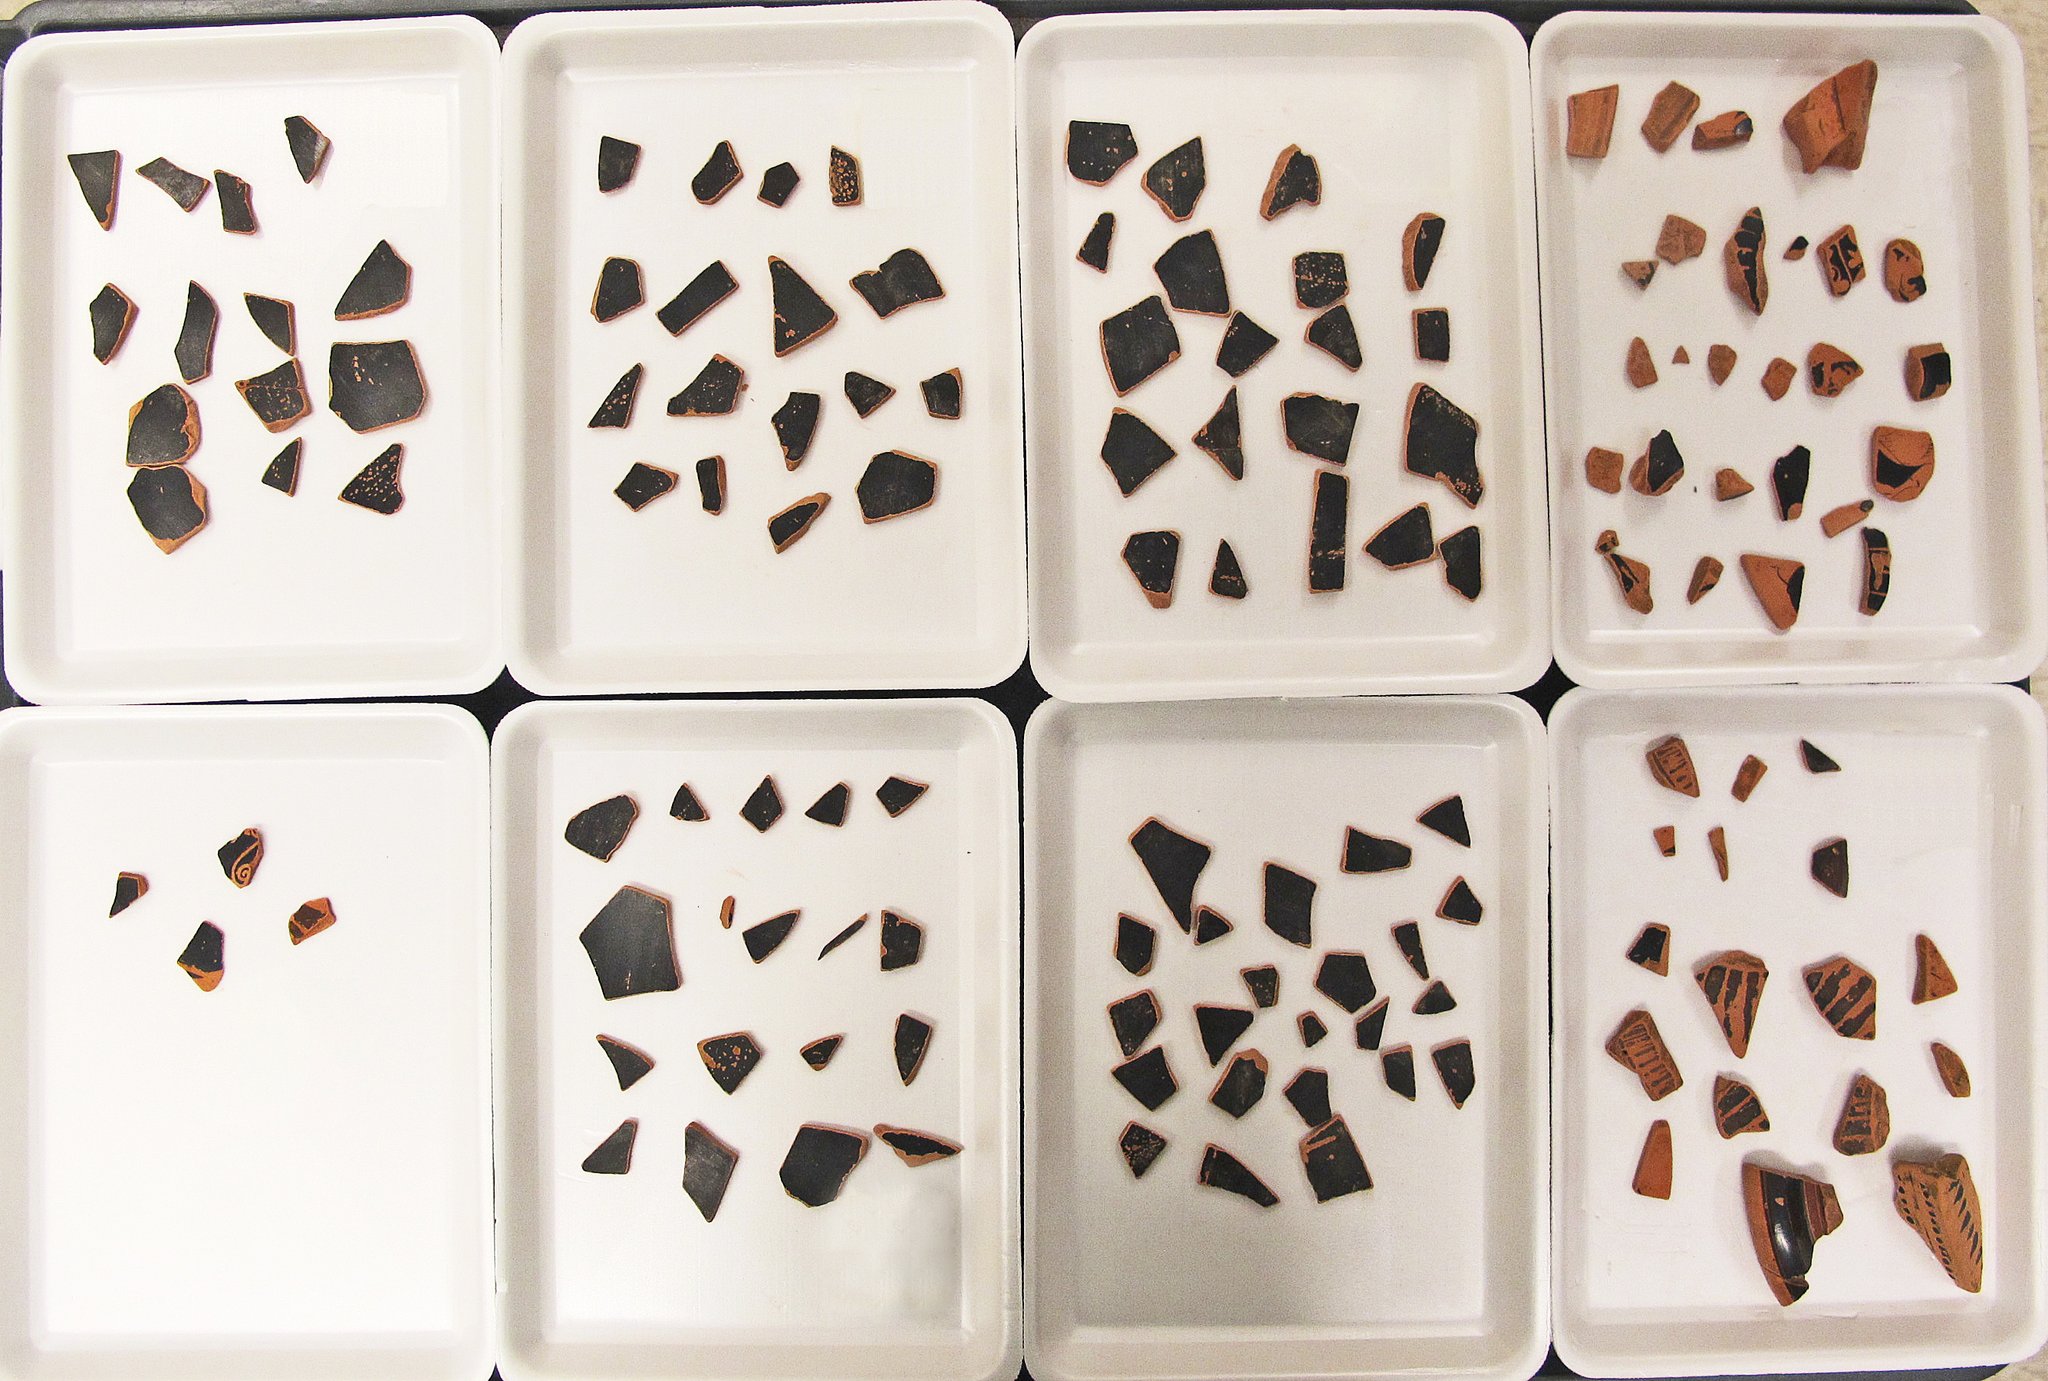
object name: vase fragment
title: Terracotta fragments of a psykter-column-krater joining 1986.11.12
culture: greek, attic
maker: troilos painter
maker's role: artist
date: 480-470 BCE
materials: terracotta